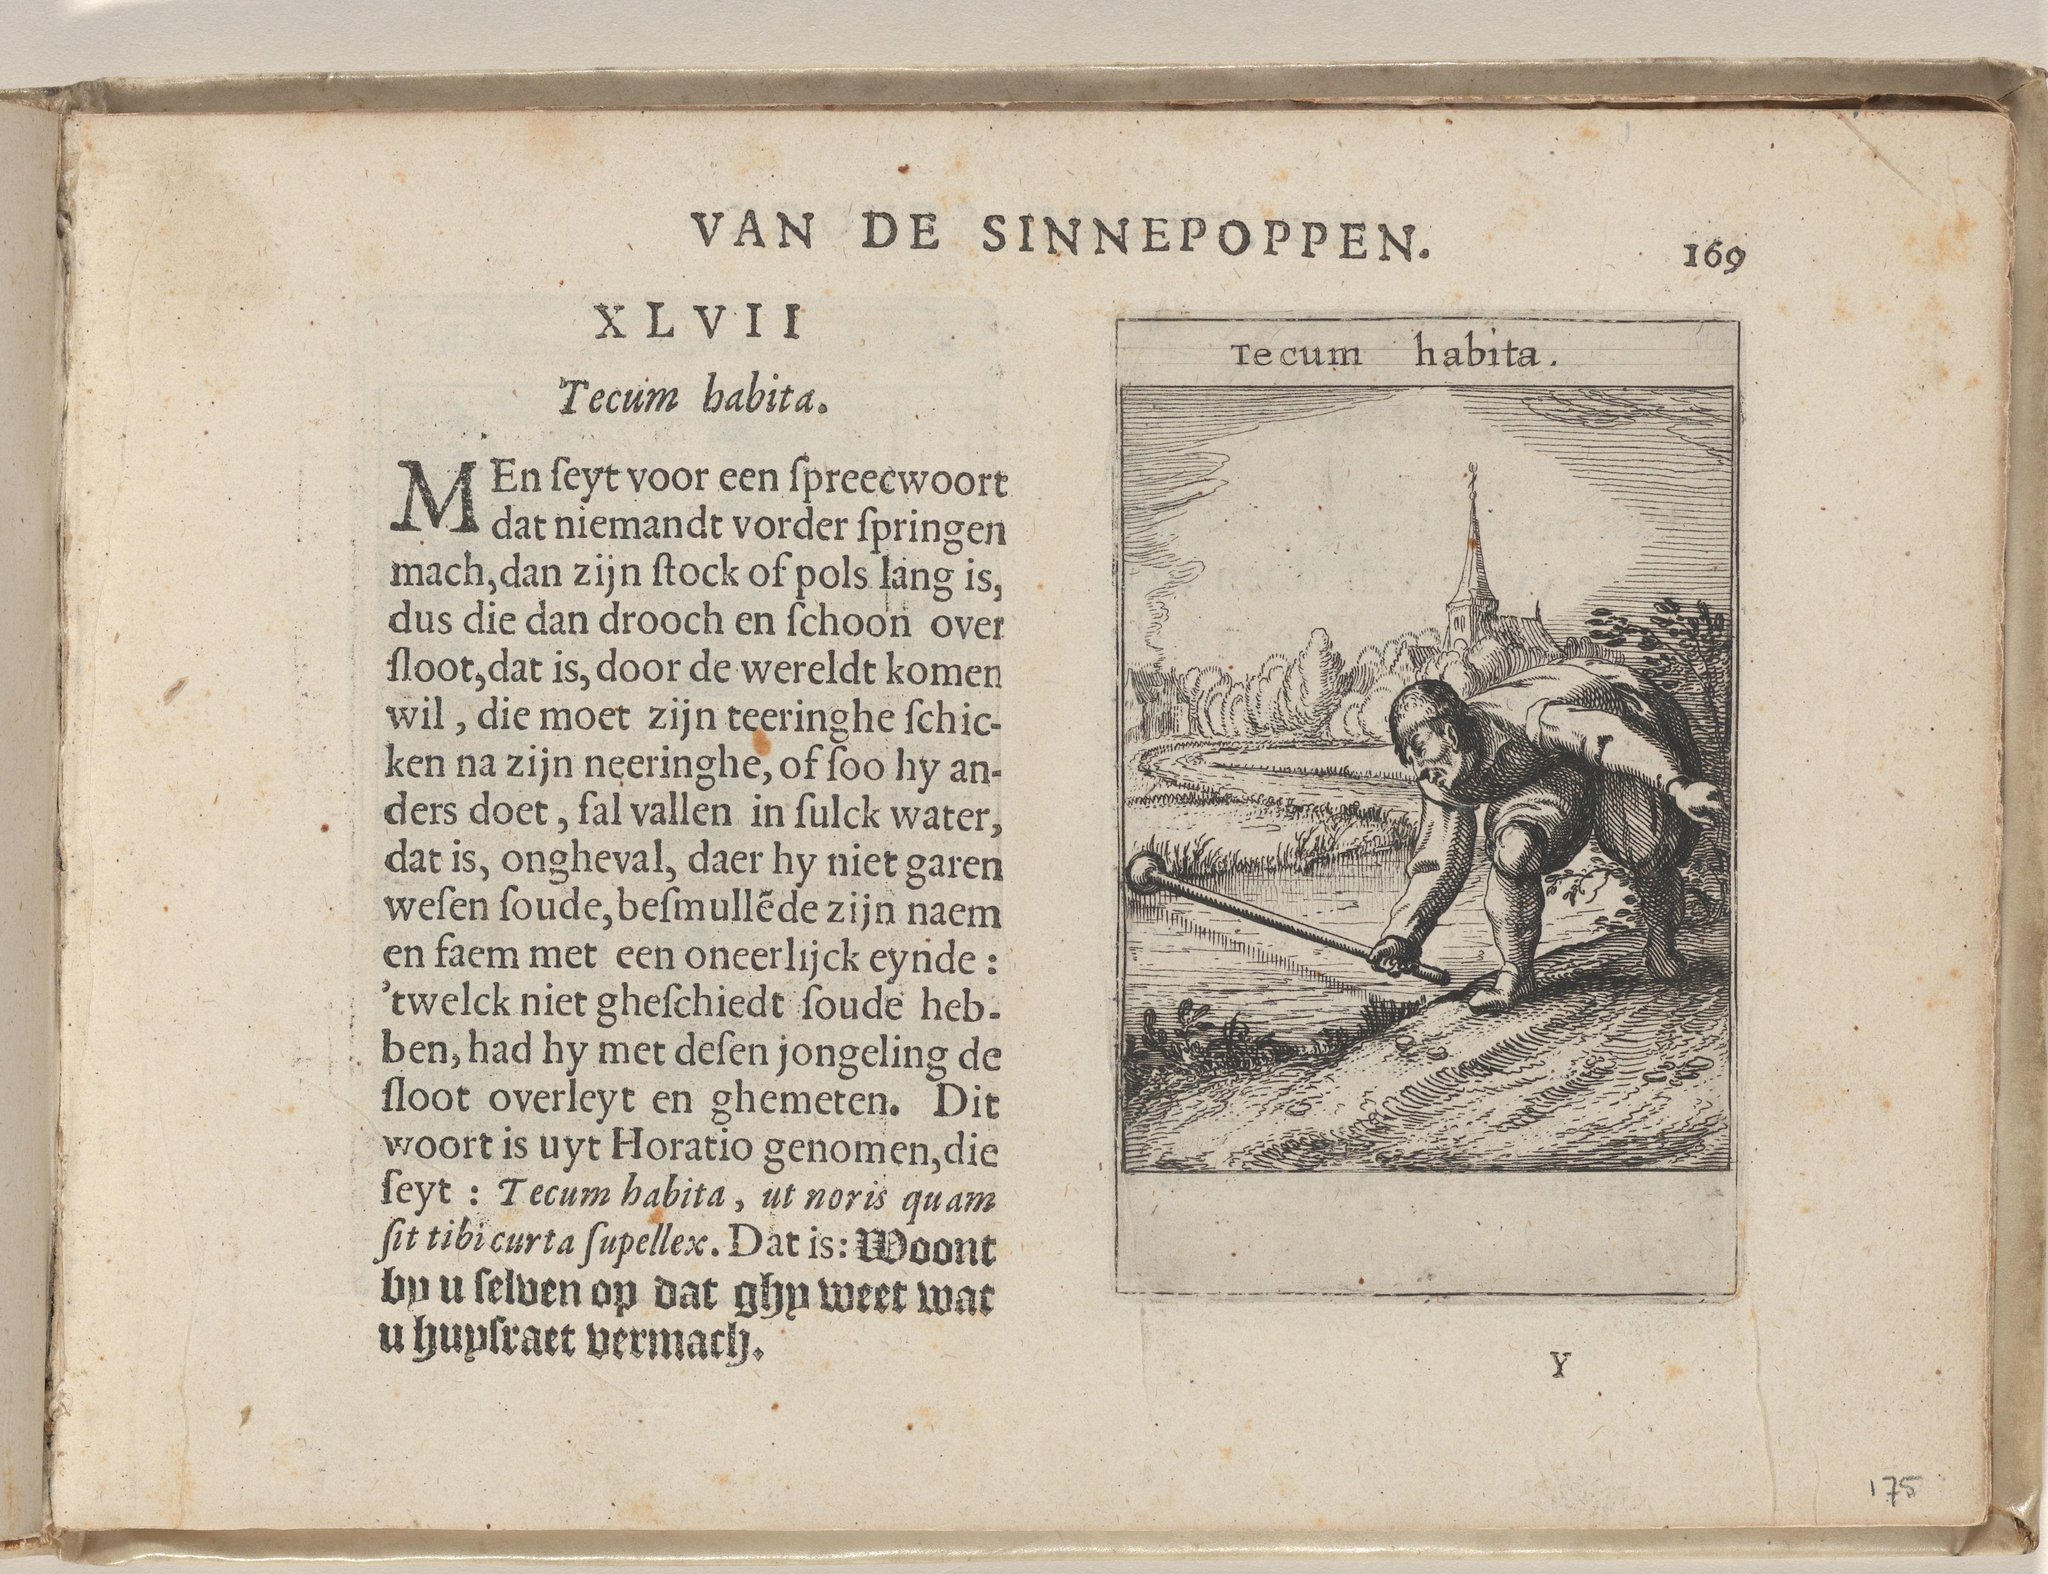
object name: print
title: XLVII tecum habita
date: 1614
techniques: engraving, printing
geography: amsterdam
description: XLVII tecum habita. Derde schok. Onderdeel van 'Sinnepoppen', R. Visscher, 1614.